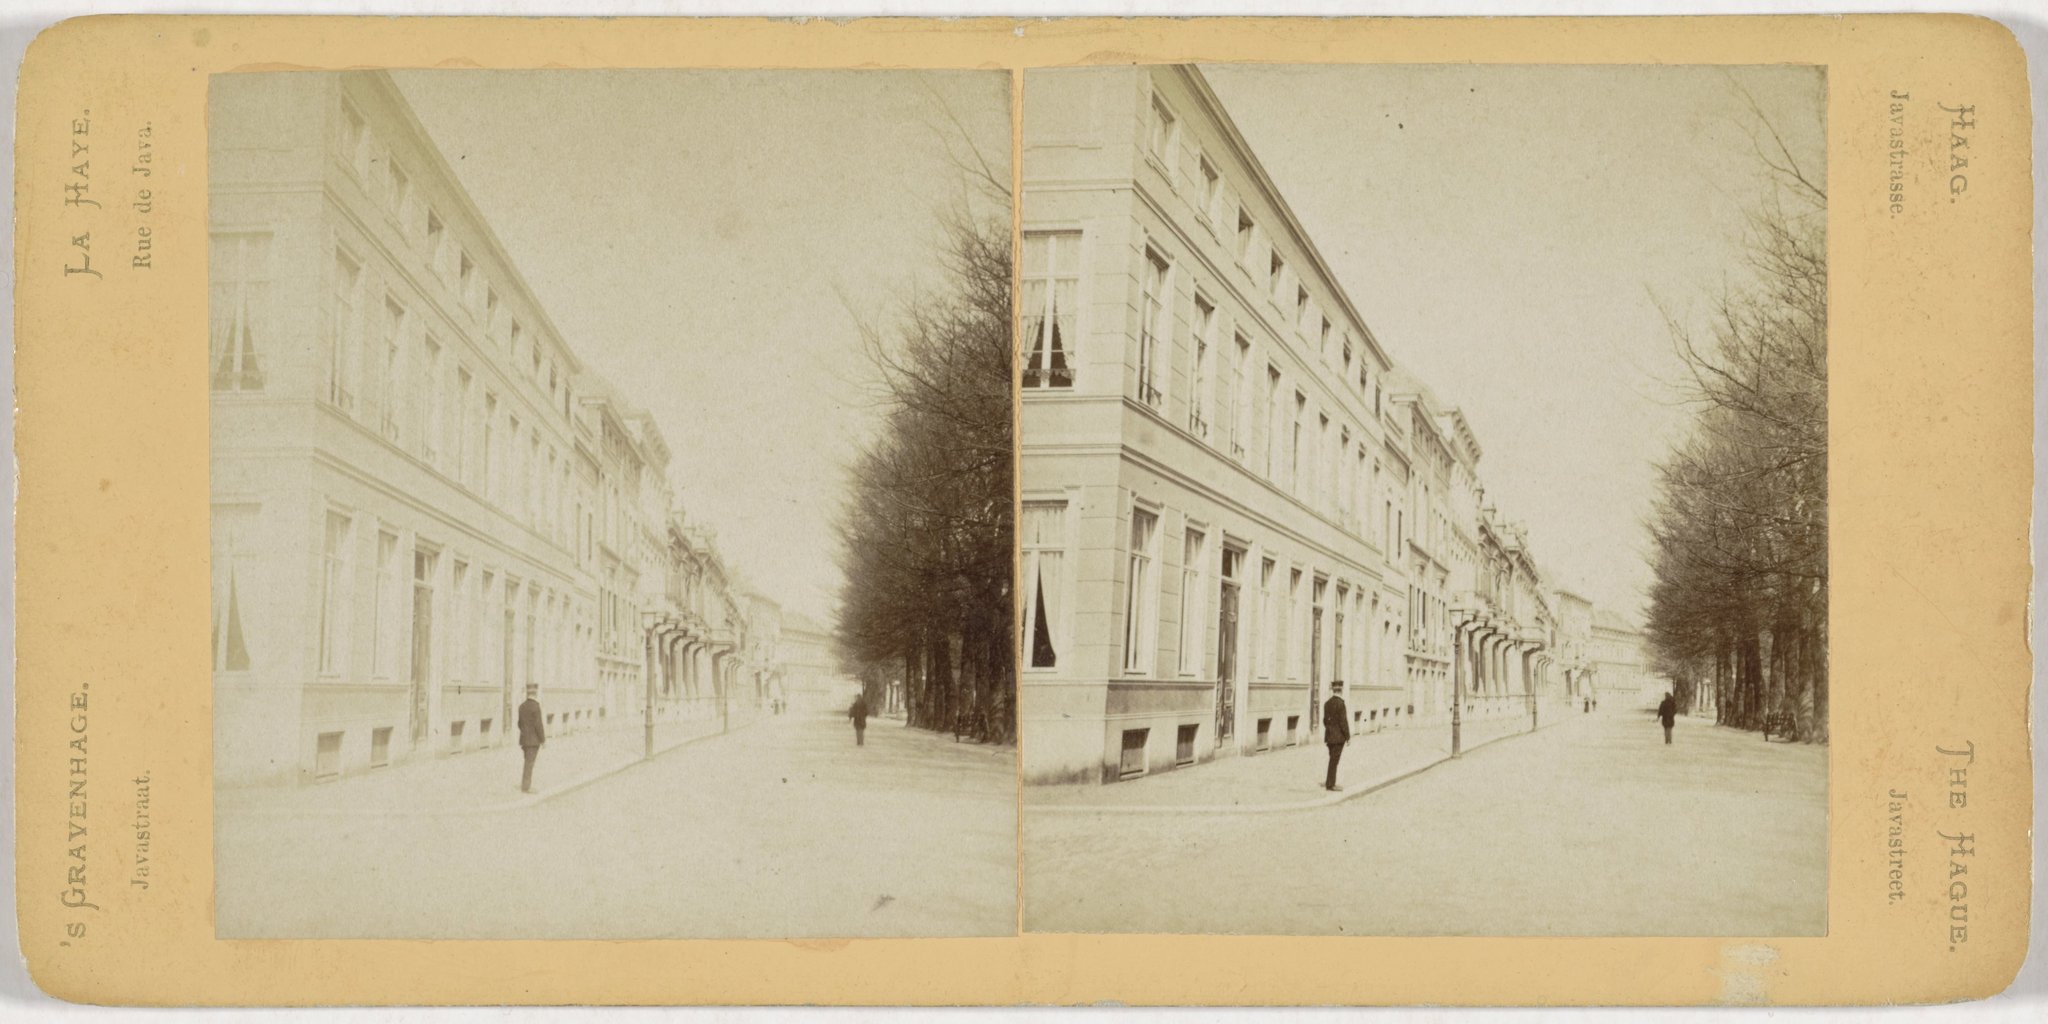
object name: stereograph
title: 's Gravenhage. / La Haye. / Haag. / The Hague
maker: Anonymous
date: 1885-1890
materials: cardboard, paper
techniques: albumen print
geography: the hague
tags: street, the hague